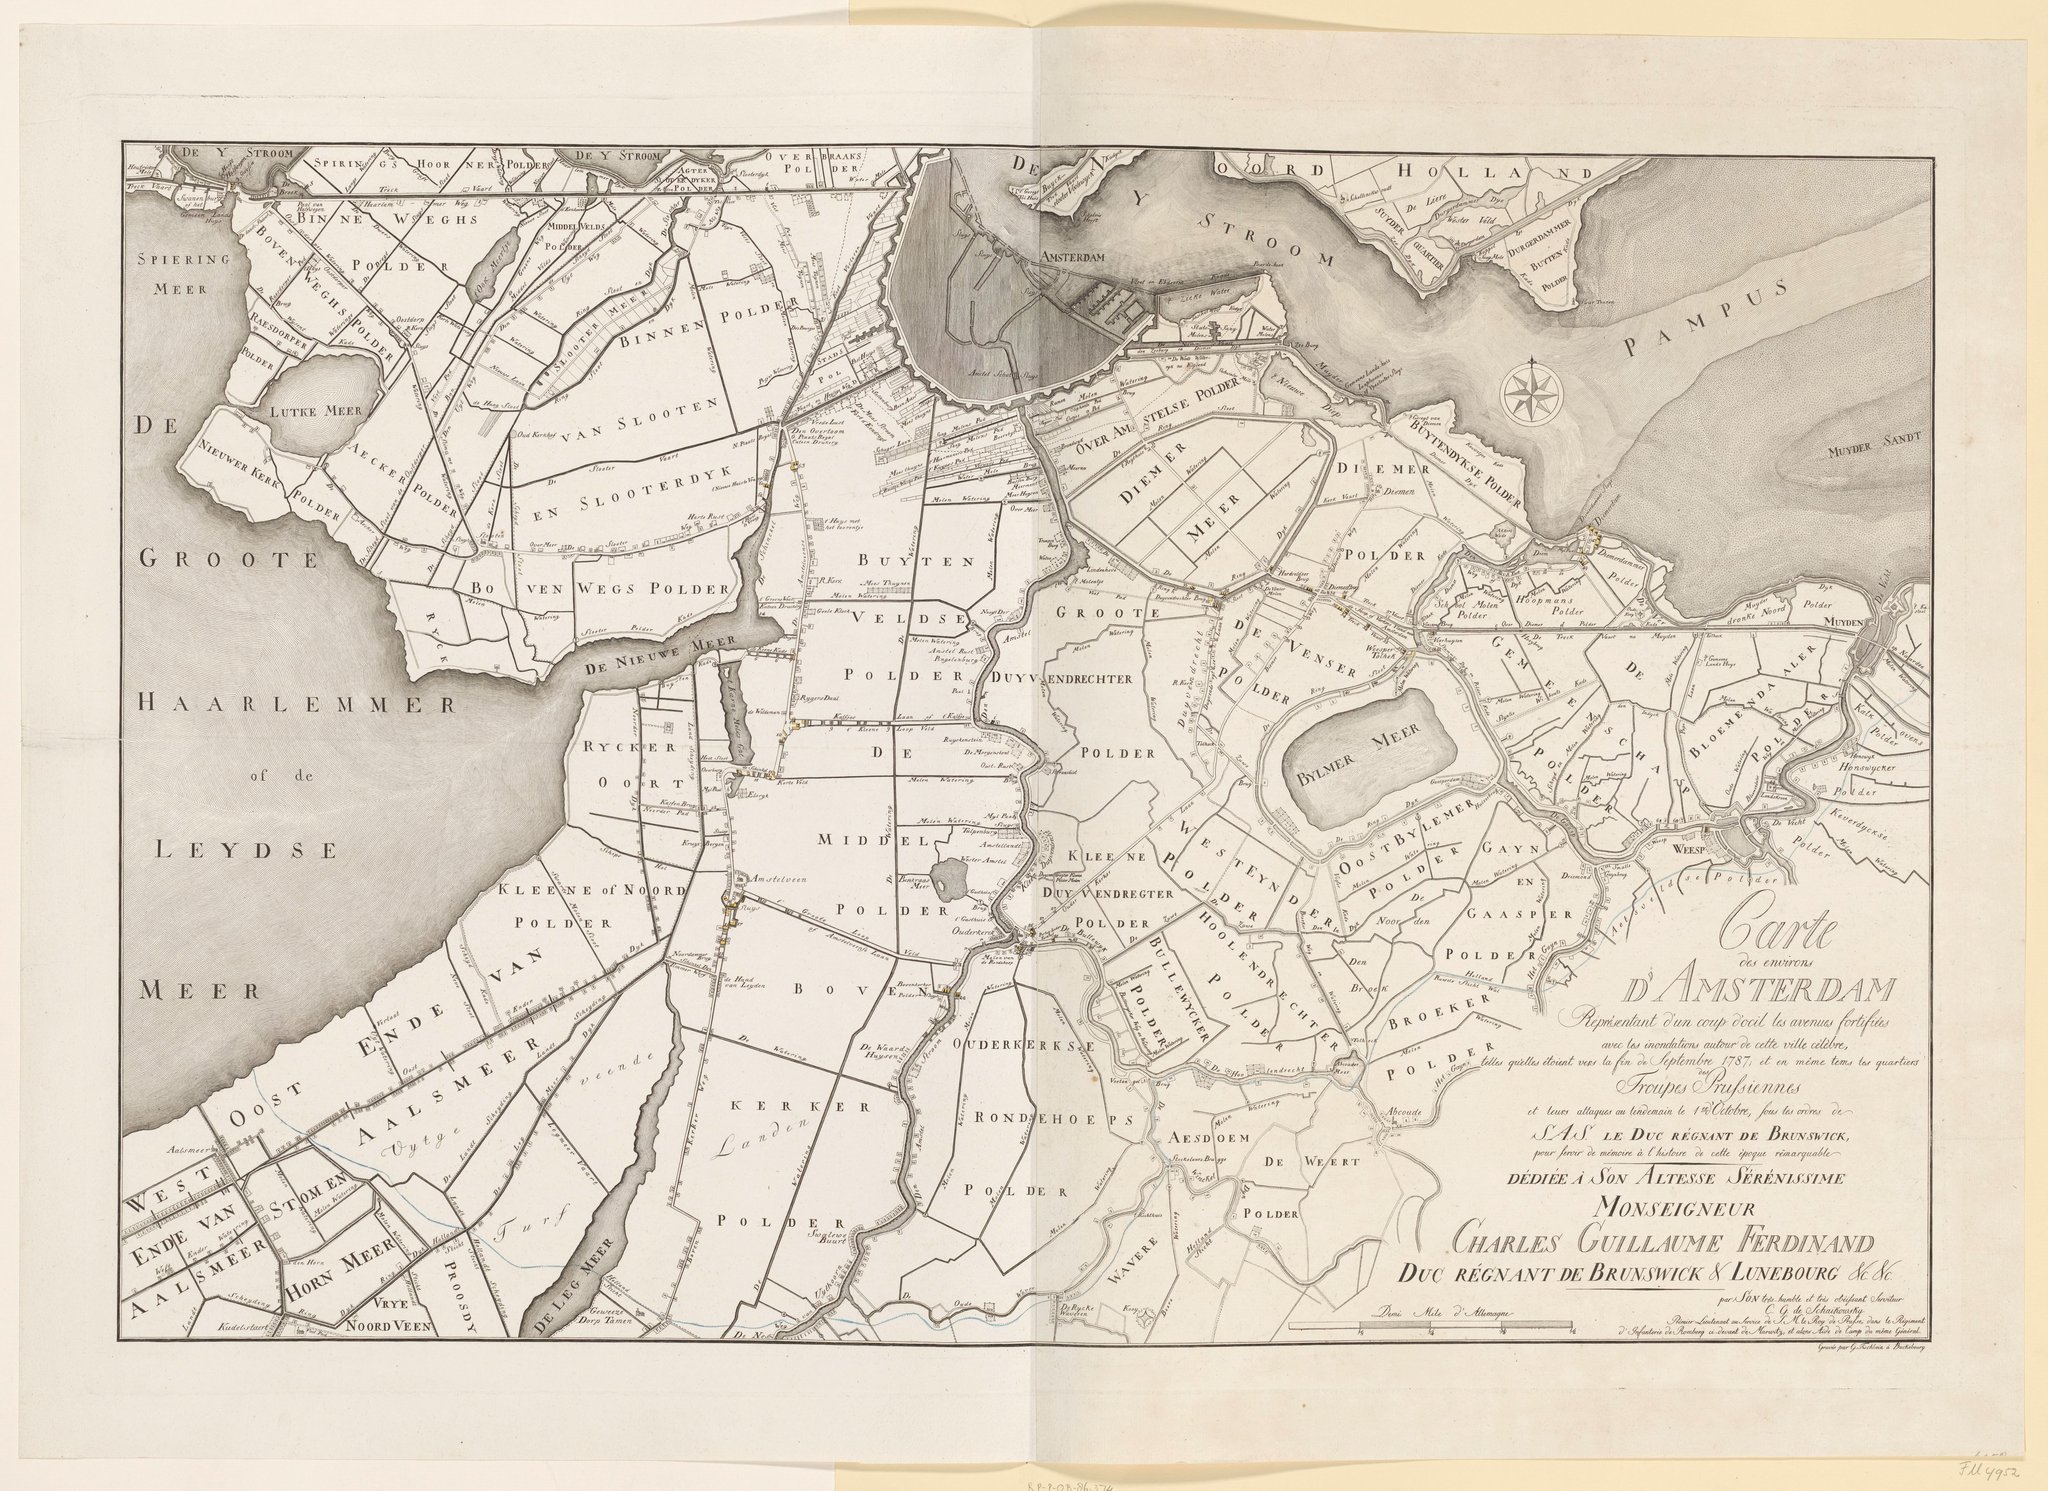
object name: print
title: Kaart van Amsterdam en de posities van de Pruisische troepen rondom de stad, 1787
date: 1788-1789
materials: paper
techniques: etching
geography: bückeburg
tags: karel willem ferdinand hertog van brunswijk-wolfenbüttel, dike-break, maps of separate countries or regions, amsterdam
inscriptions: collector's mark: Lugt 2228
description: Kaart van Amsterdam en omstreken waarop zijn aangegeven de posities van de Pruisische troepen en het gebied dat onder water is gezet bij het naderen van de Pruisische troepen onder de hertog van Brunswijk, eind september - 1 oktober 1787. Een blauw gekleurde stippellijn geeft de omtrek van de inundatie aan.